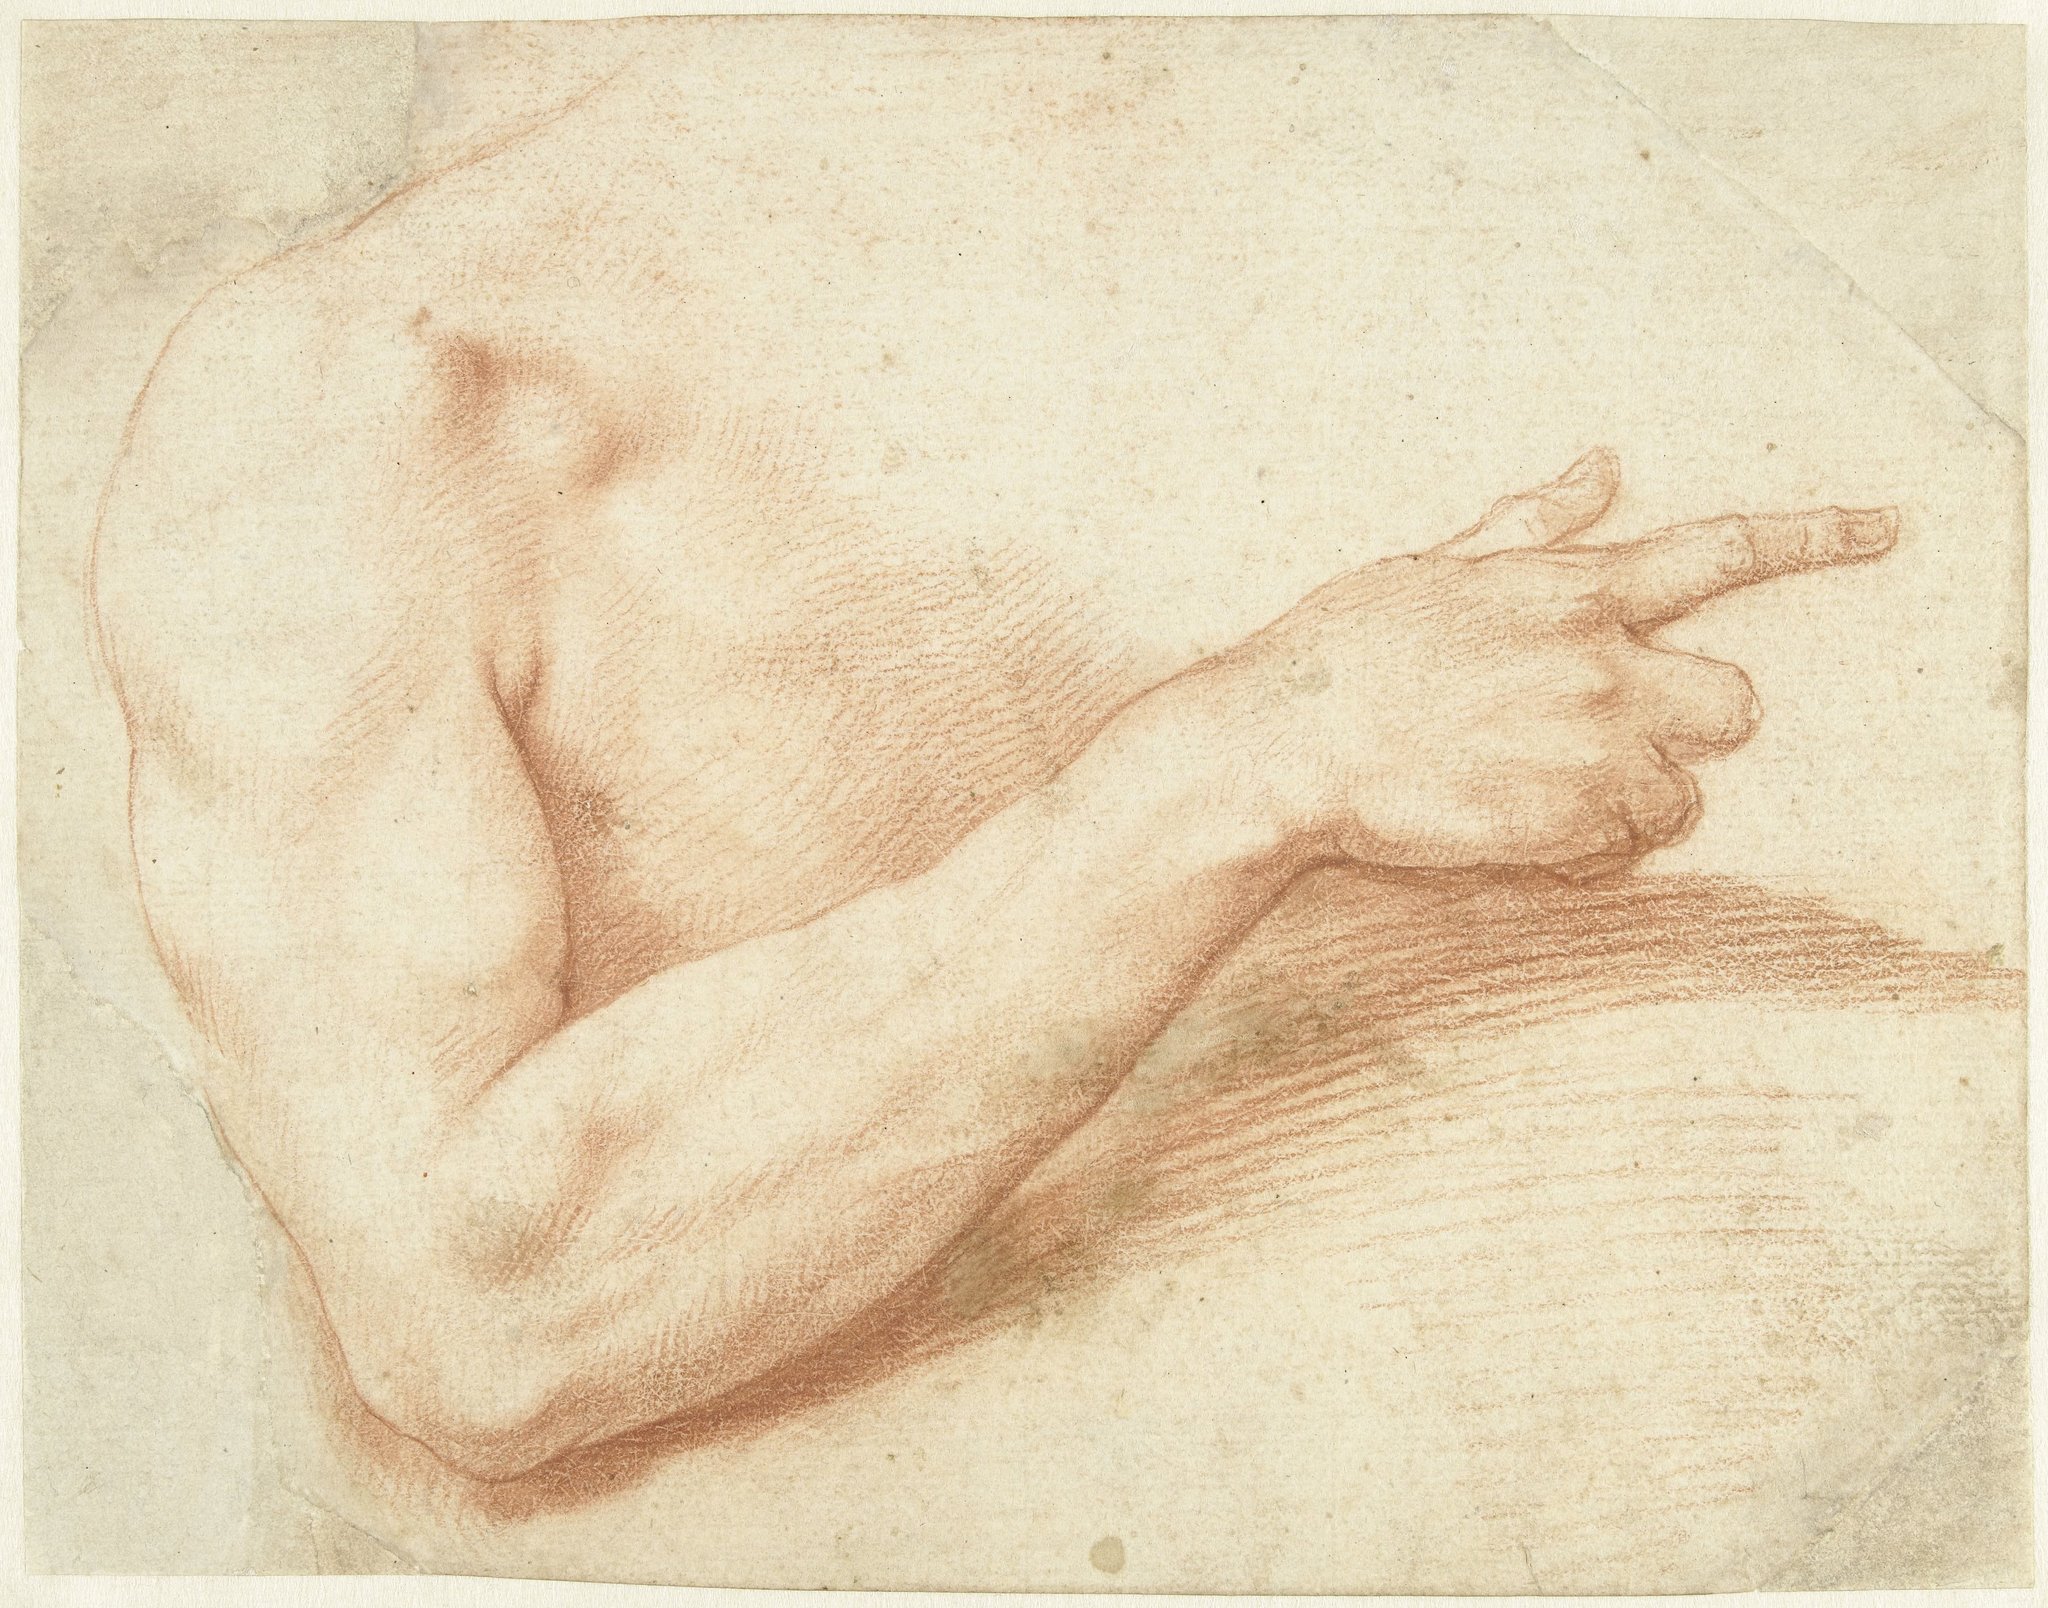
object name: drawing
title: Studie van een arm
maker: giuseppe cesari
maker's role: draughtsman, painter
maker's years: 1568-1640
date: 1578-1640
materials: chalk, paper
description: Studie van een voor de borst gehouden arm, met wijzende vinger.